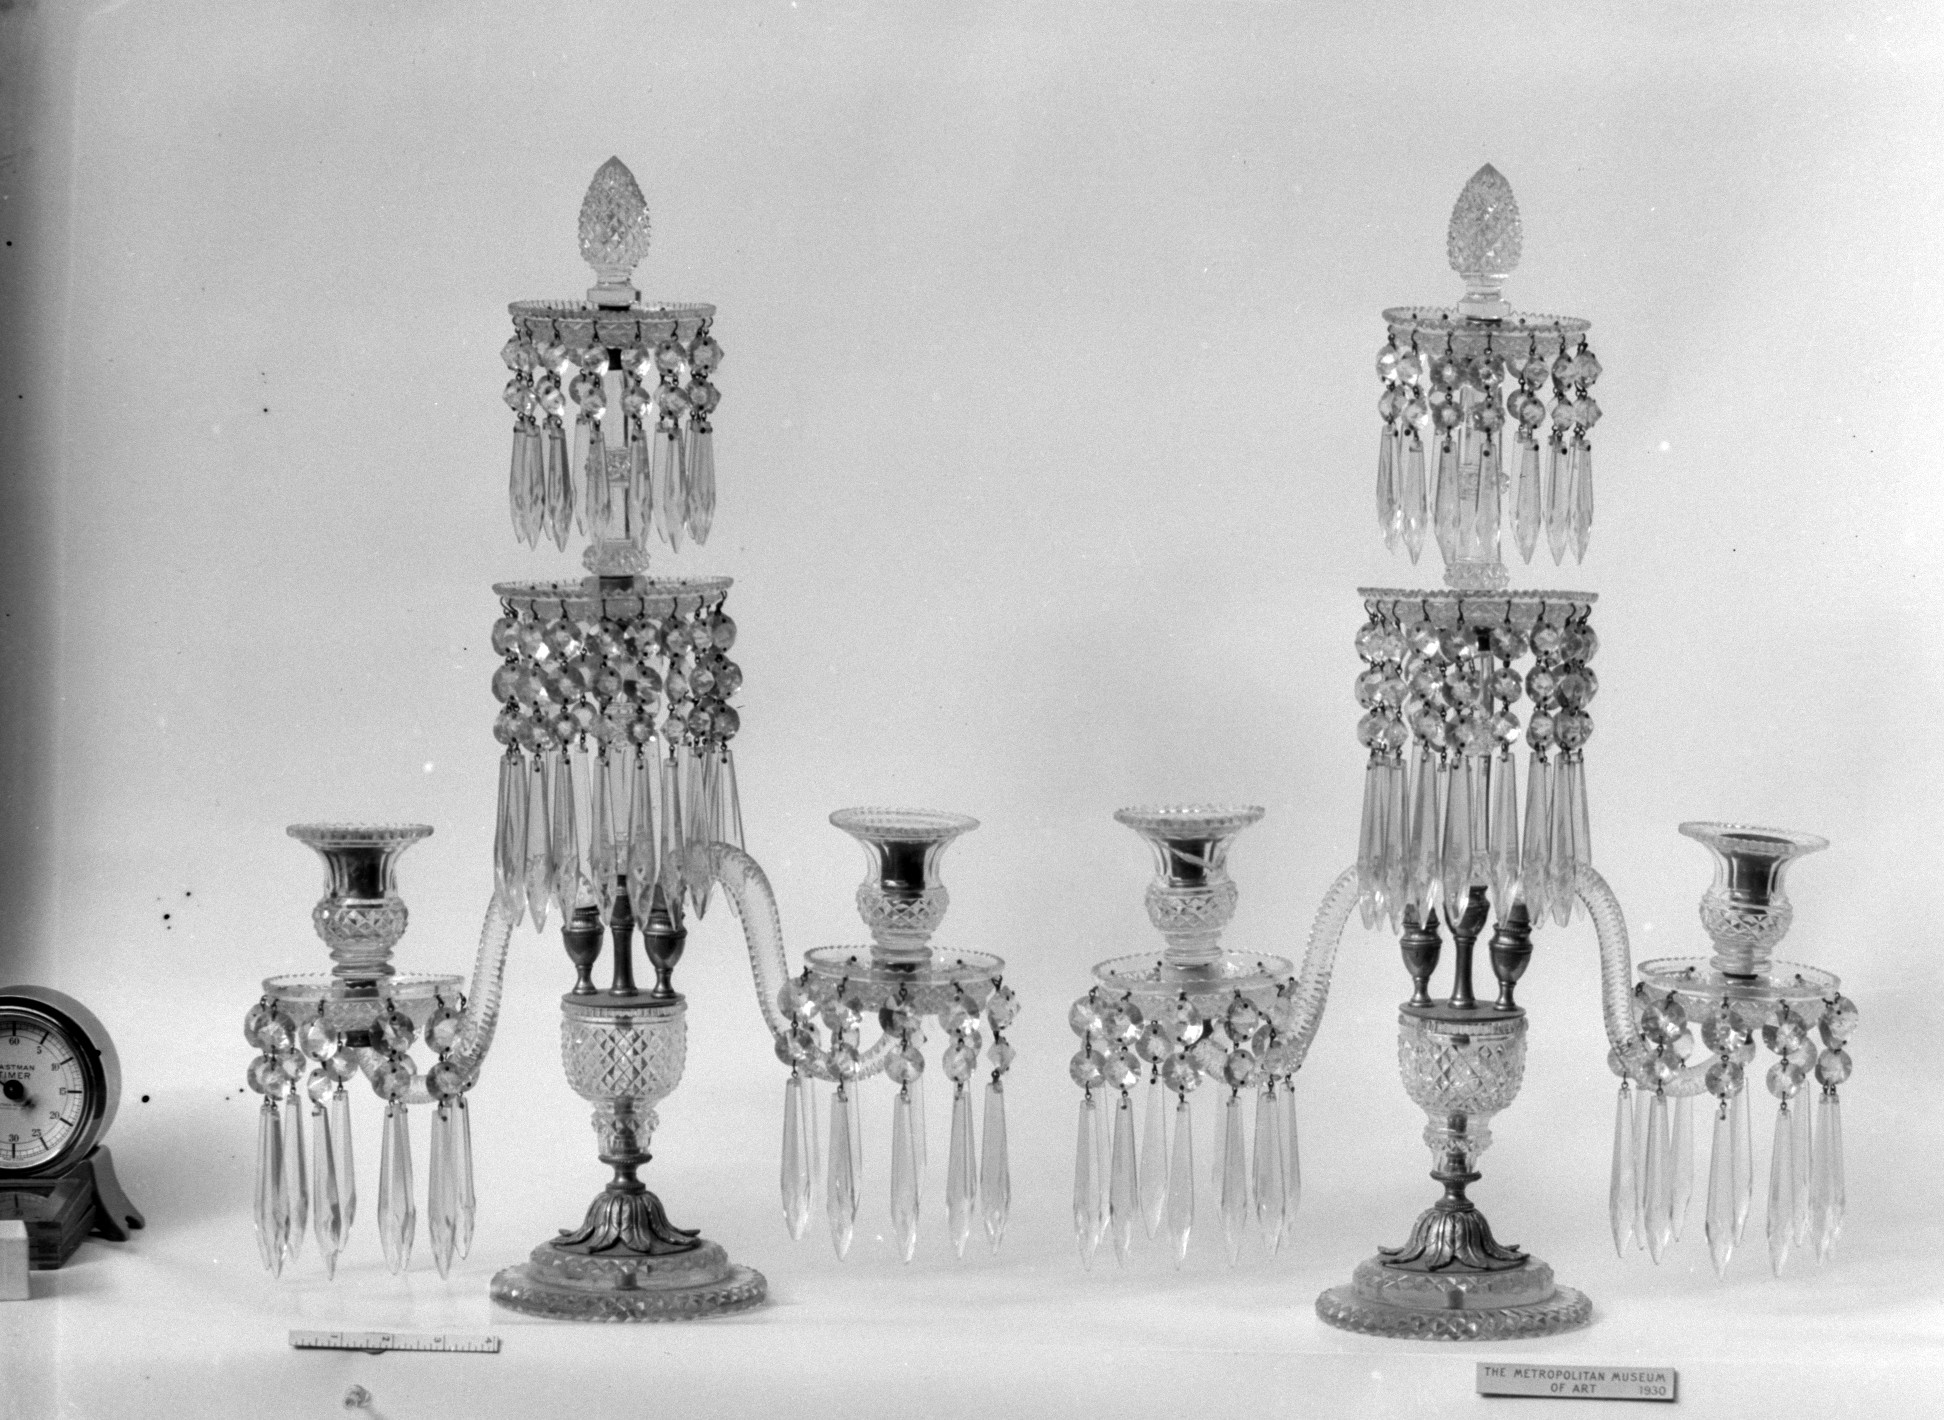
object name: candelabrum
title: Candelabrum (one of a pair)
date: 1800-1850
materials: gilt bronze, glass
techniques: glassblowing, cutting